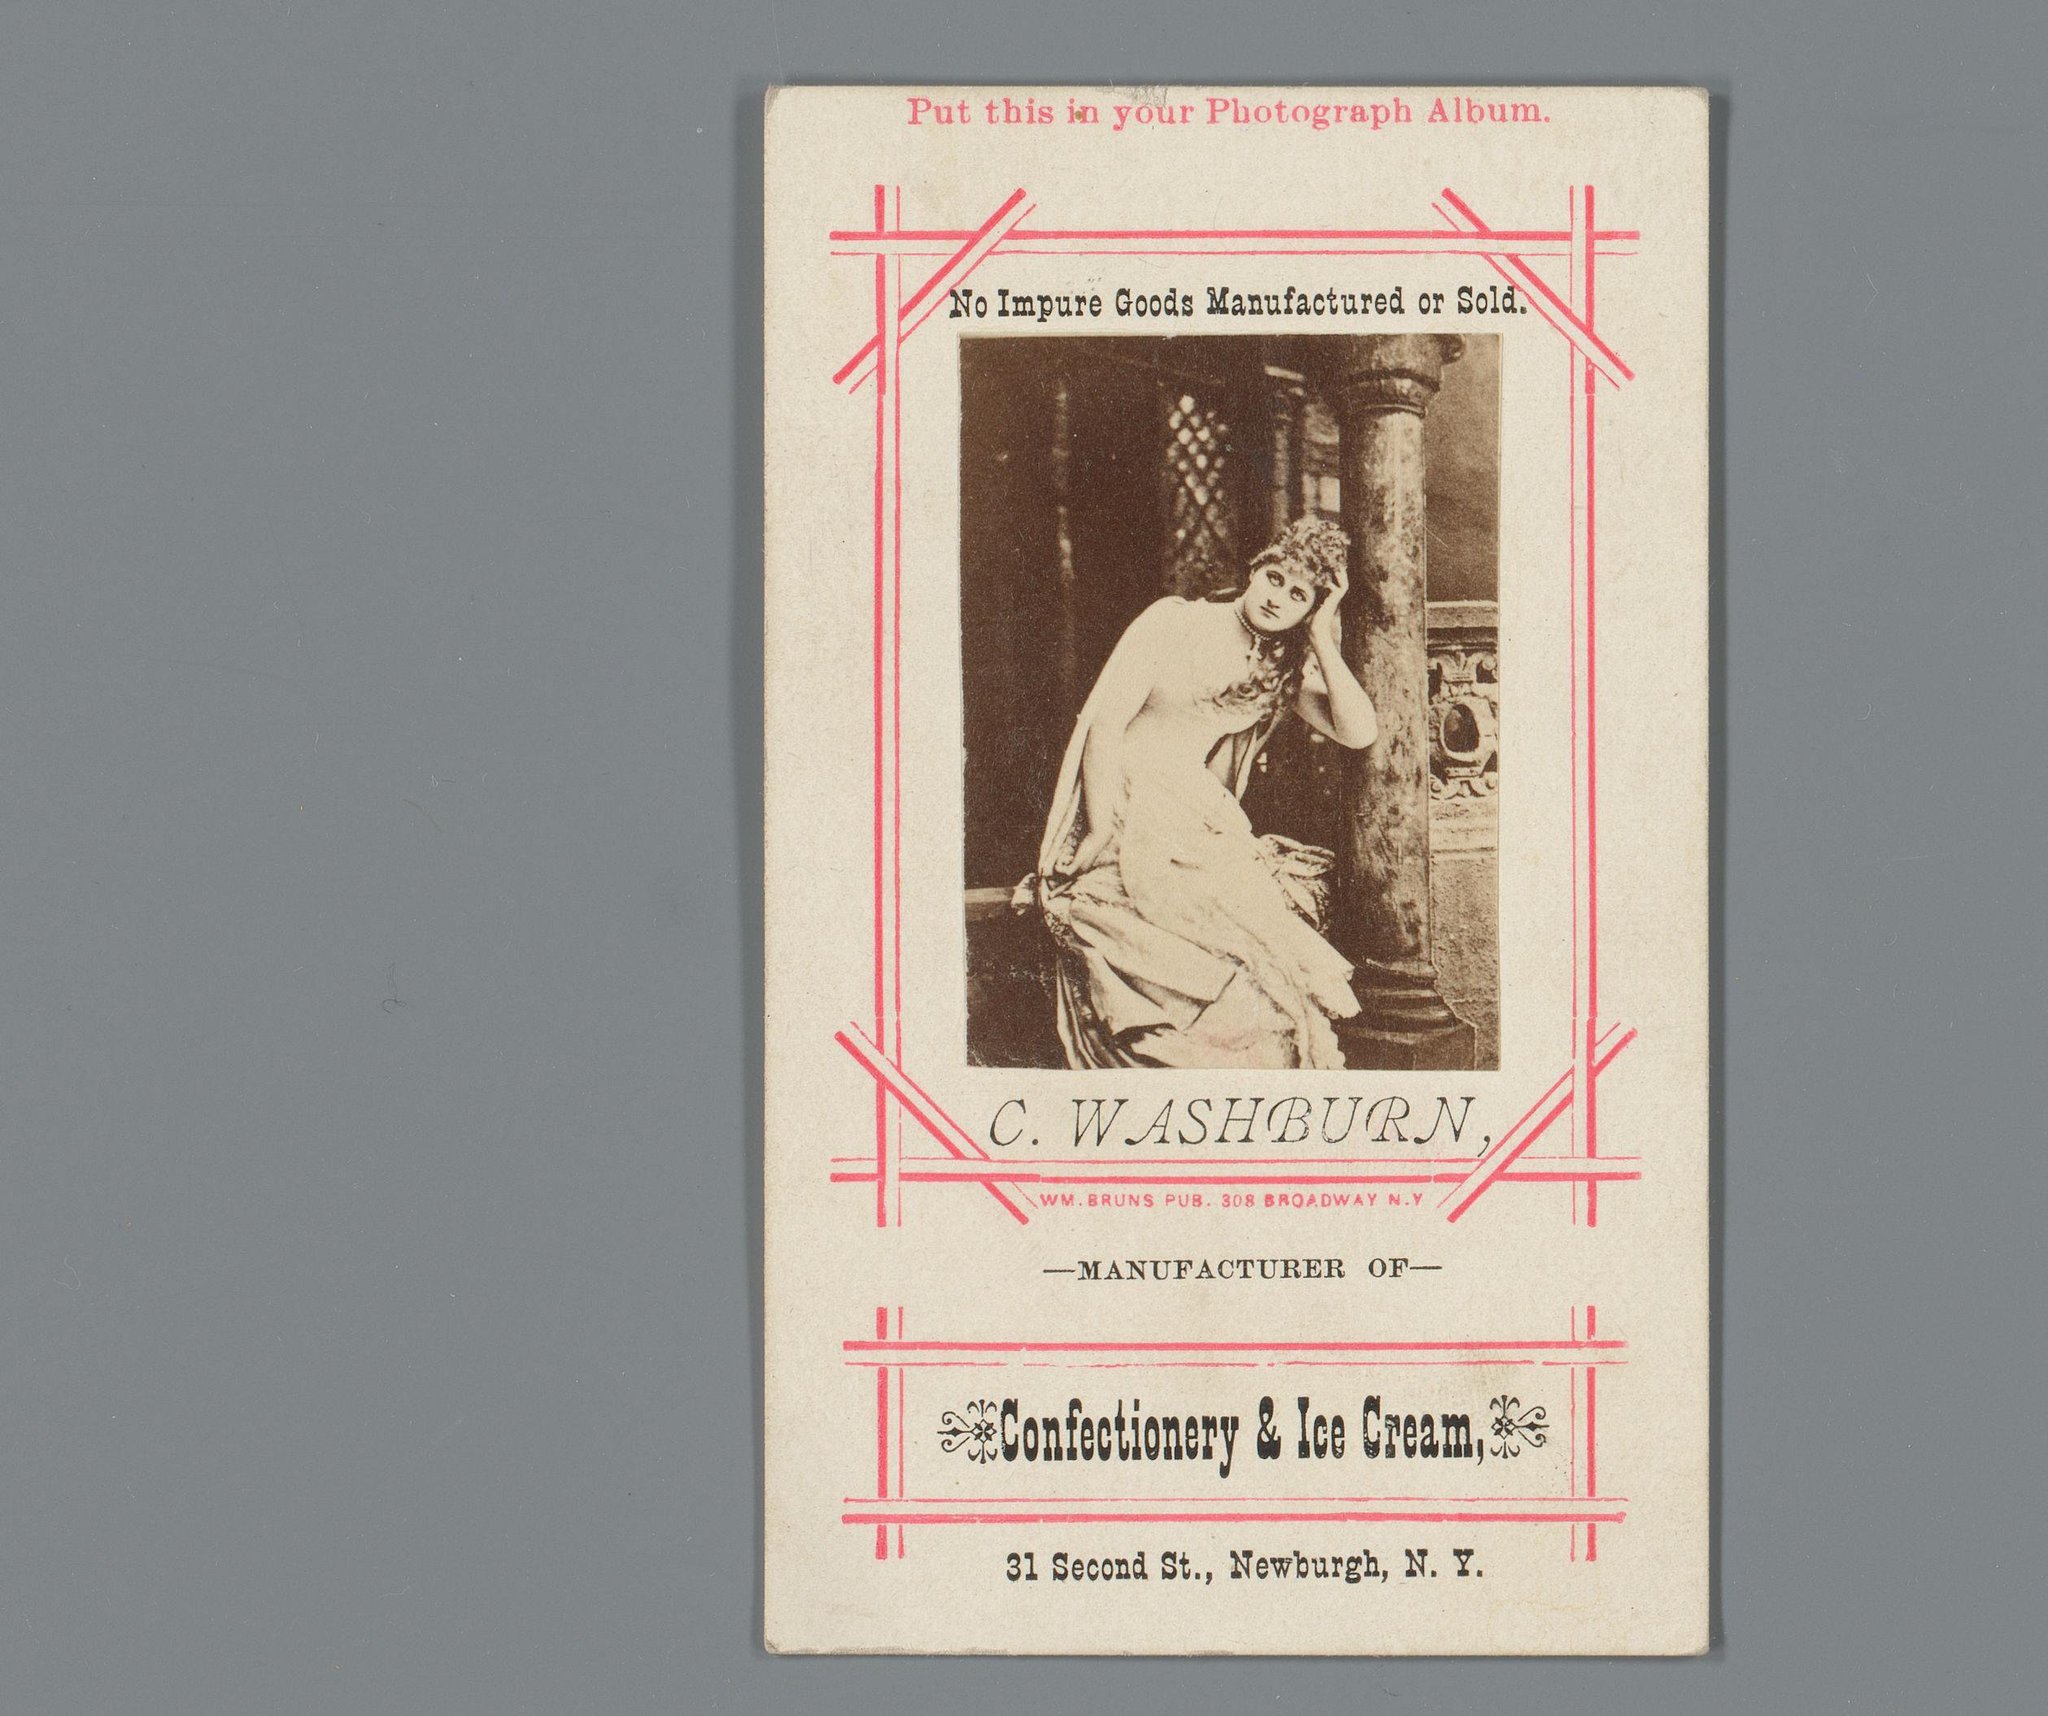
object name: carte de visite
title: Reclame voor etenswaren van C. Washburn in Newburgh, New York, met portret van een onbekende vrouw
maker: william bruns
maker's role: fotograaf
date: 1850-1915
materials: cardboard, photographic support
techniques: albumen print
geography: new york city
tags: advertising, historical persons not known by name - bb - woman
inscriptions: inscription: ‘WM. BRUNS PUB. 308 BROADWAY N.Y.’